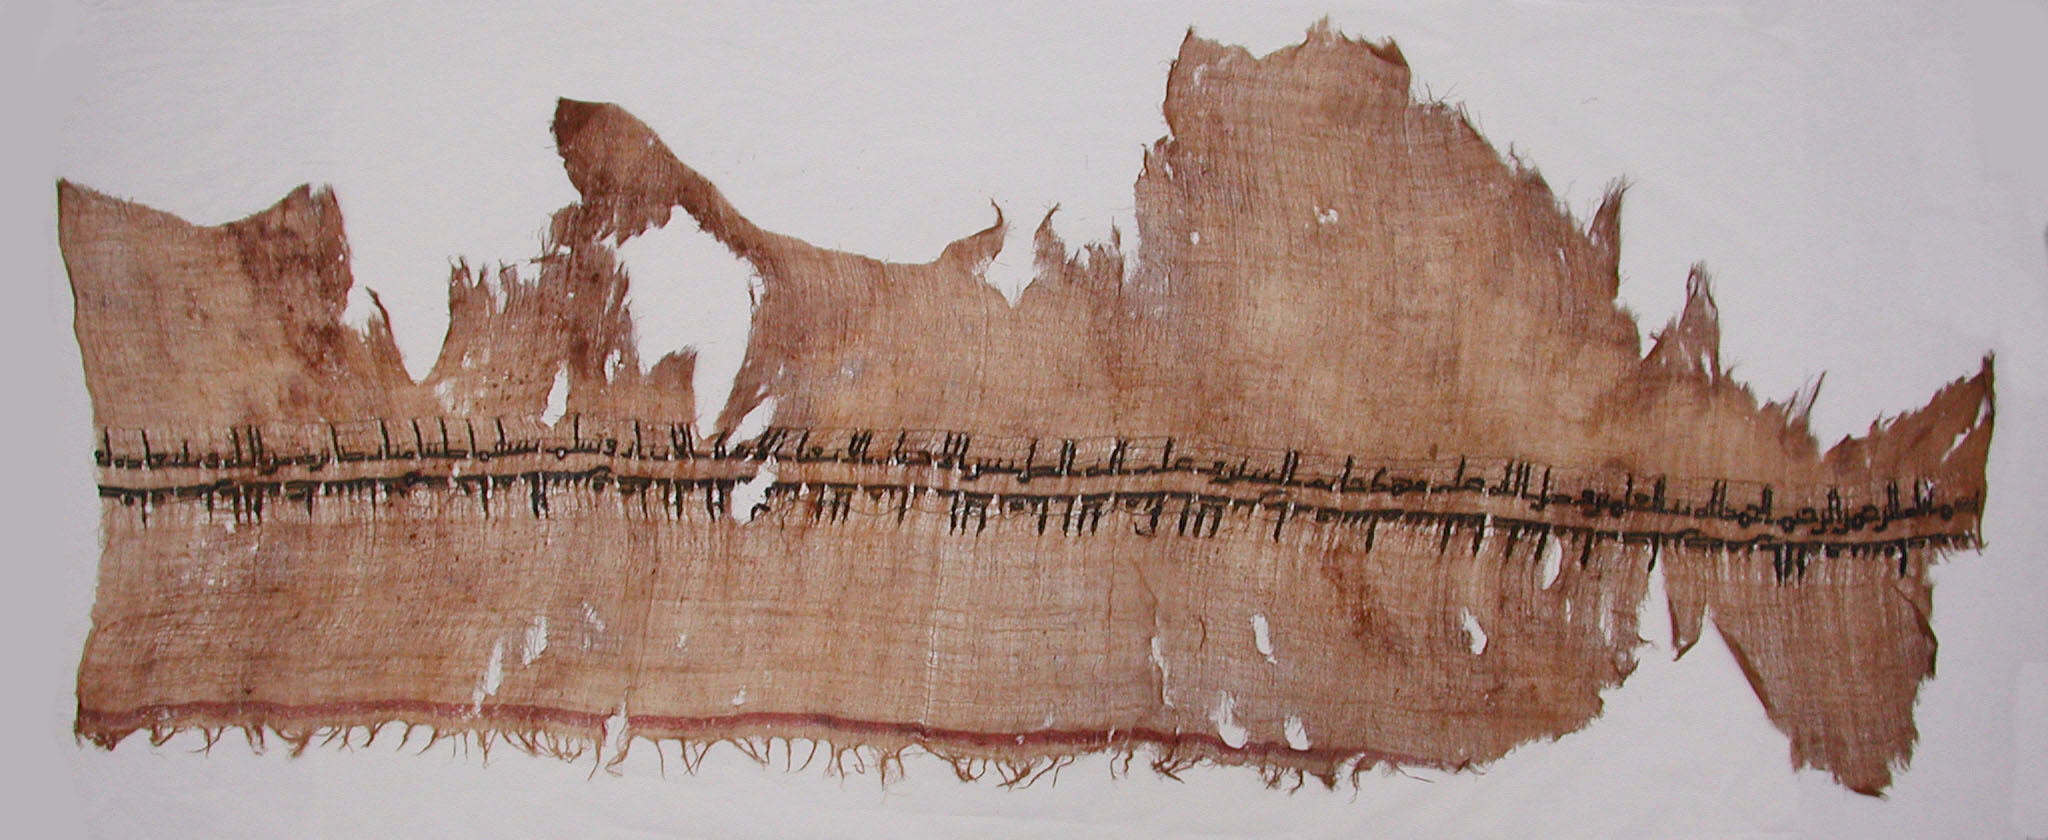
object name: textile fragment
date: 901-1000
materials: linen, silk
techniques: weave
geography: egypt